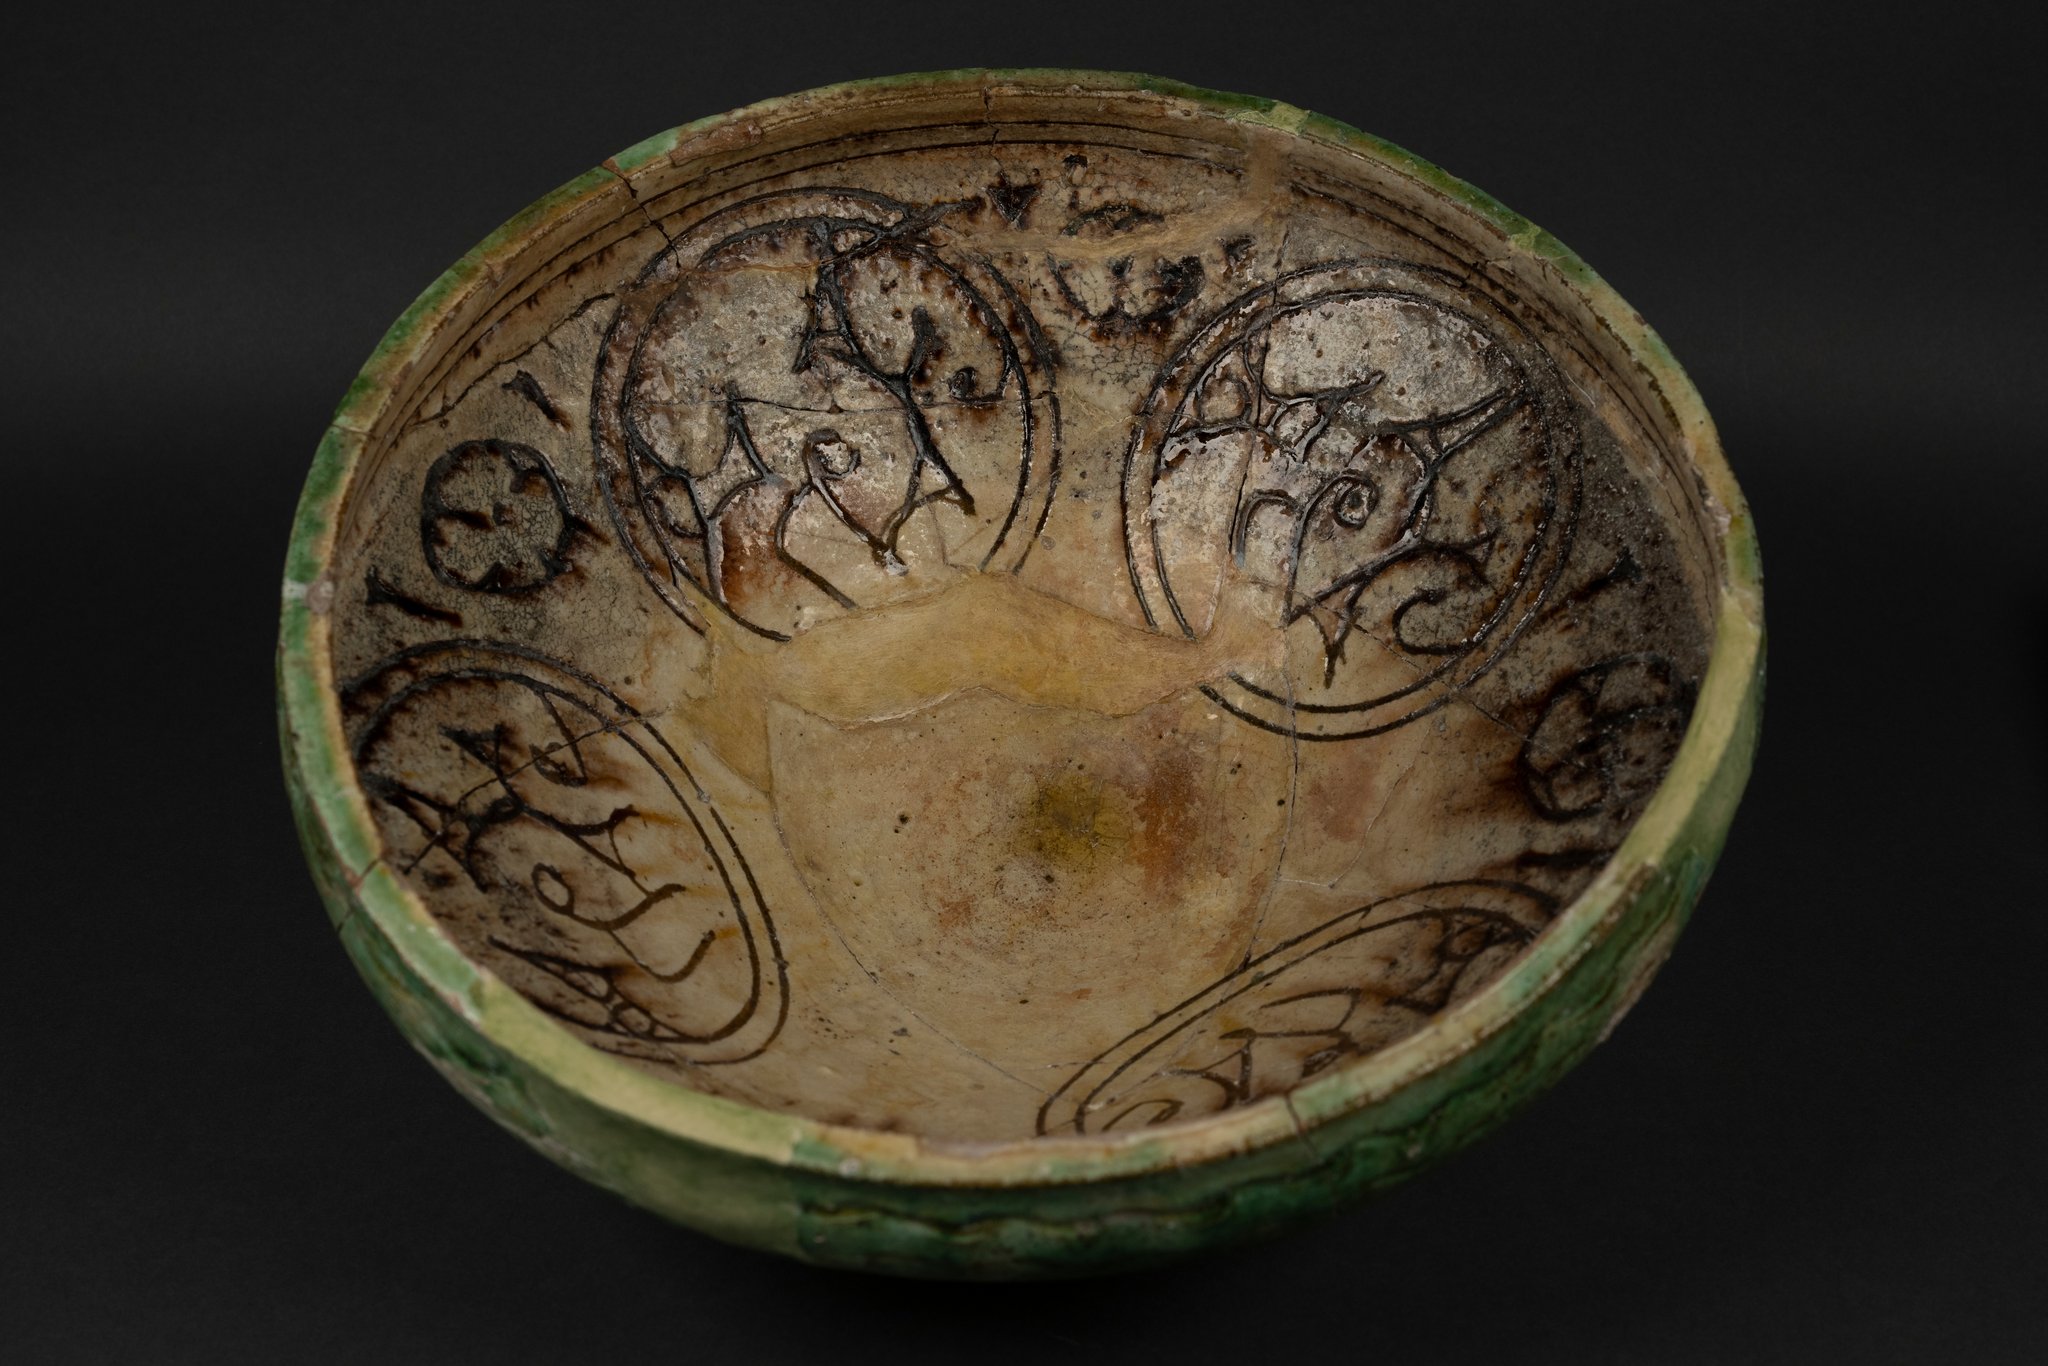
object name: bowl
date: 1001-1200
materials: earthenware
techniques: painting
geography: iran